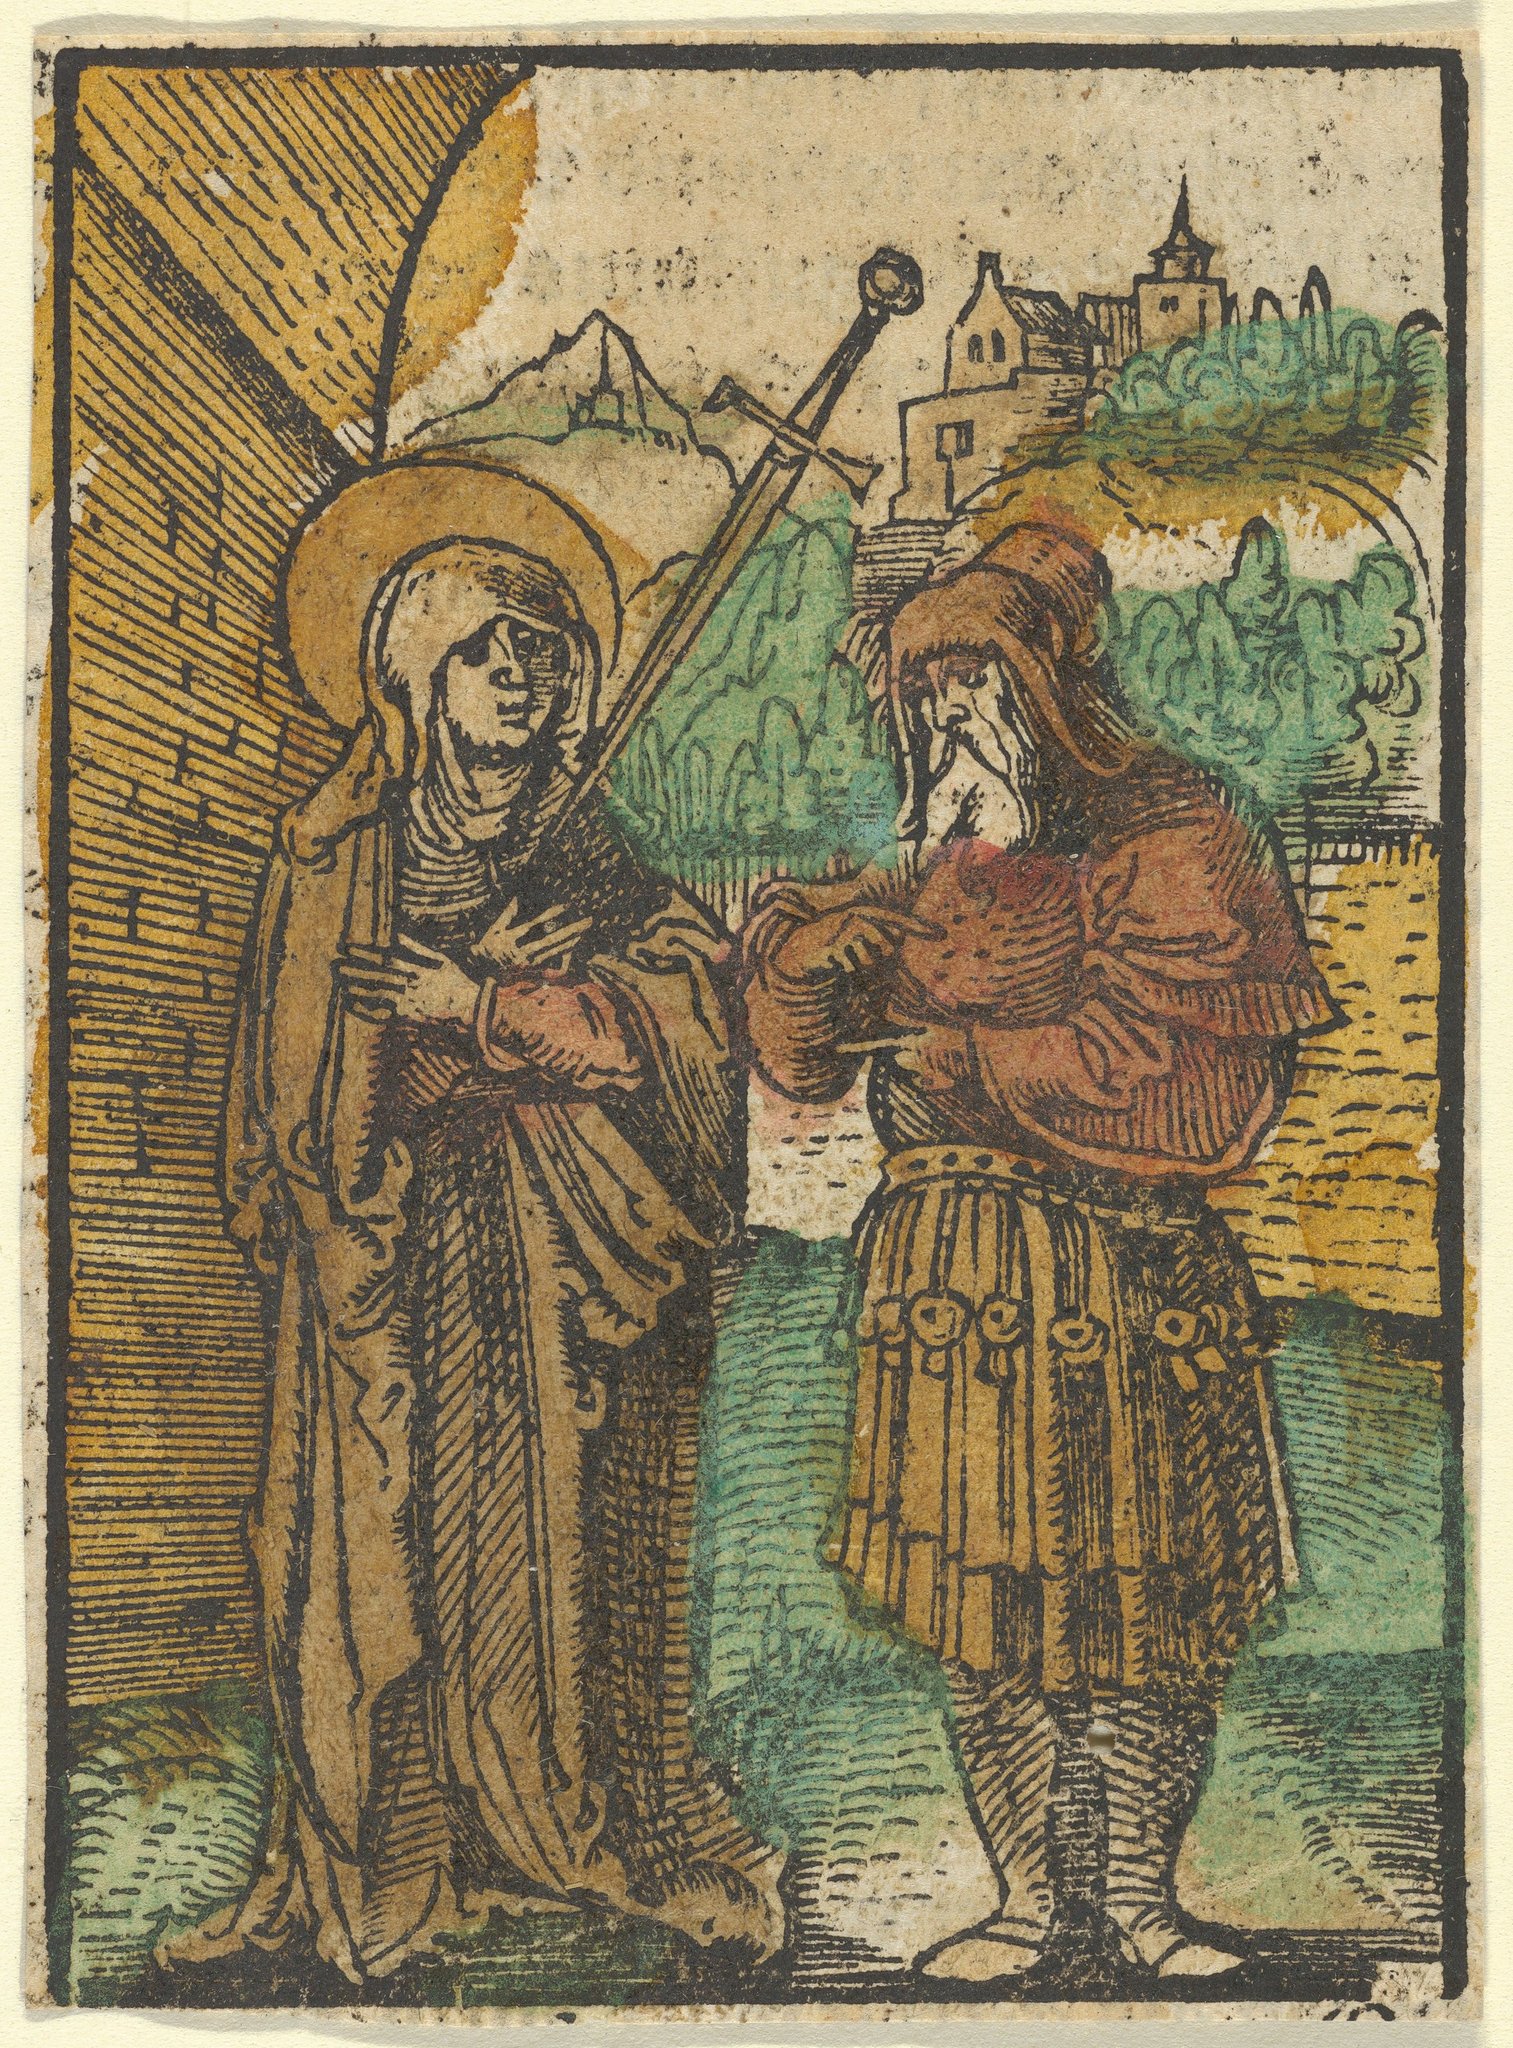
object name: print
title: The Virgin as Master Dolorosa and Simeon, from Das Plenarium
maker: hans schäufelein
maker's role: artist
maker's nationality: german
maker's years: 1480-1540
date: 1517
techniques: hand coloring, woodcut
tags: men,virgin mary